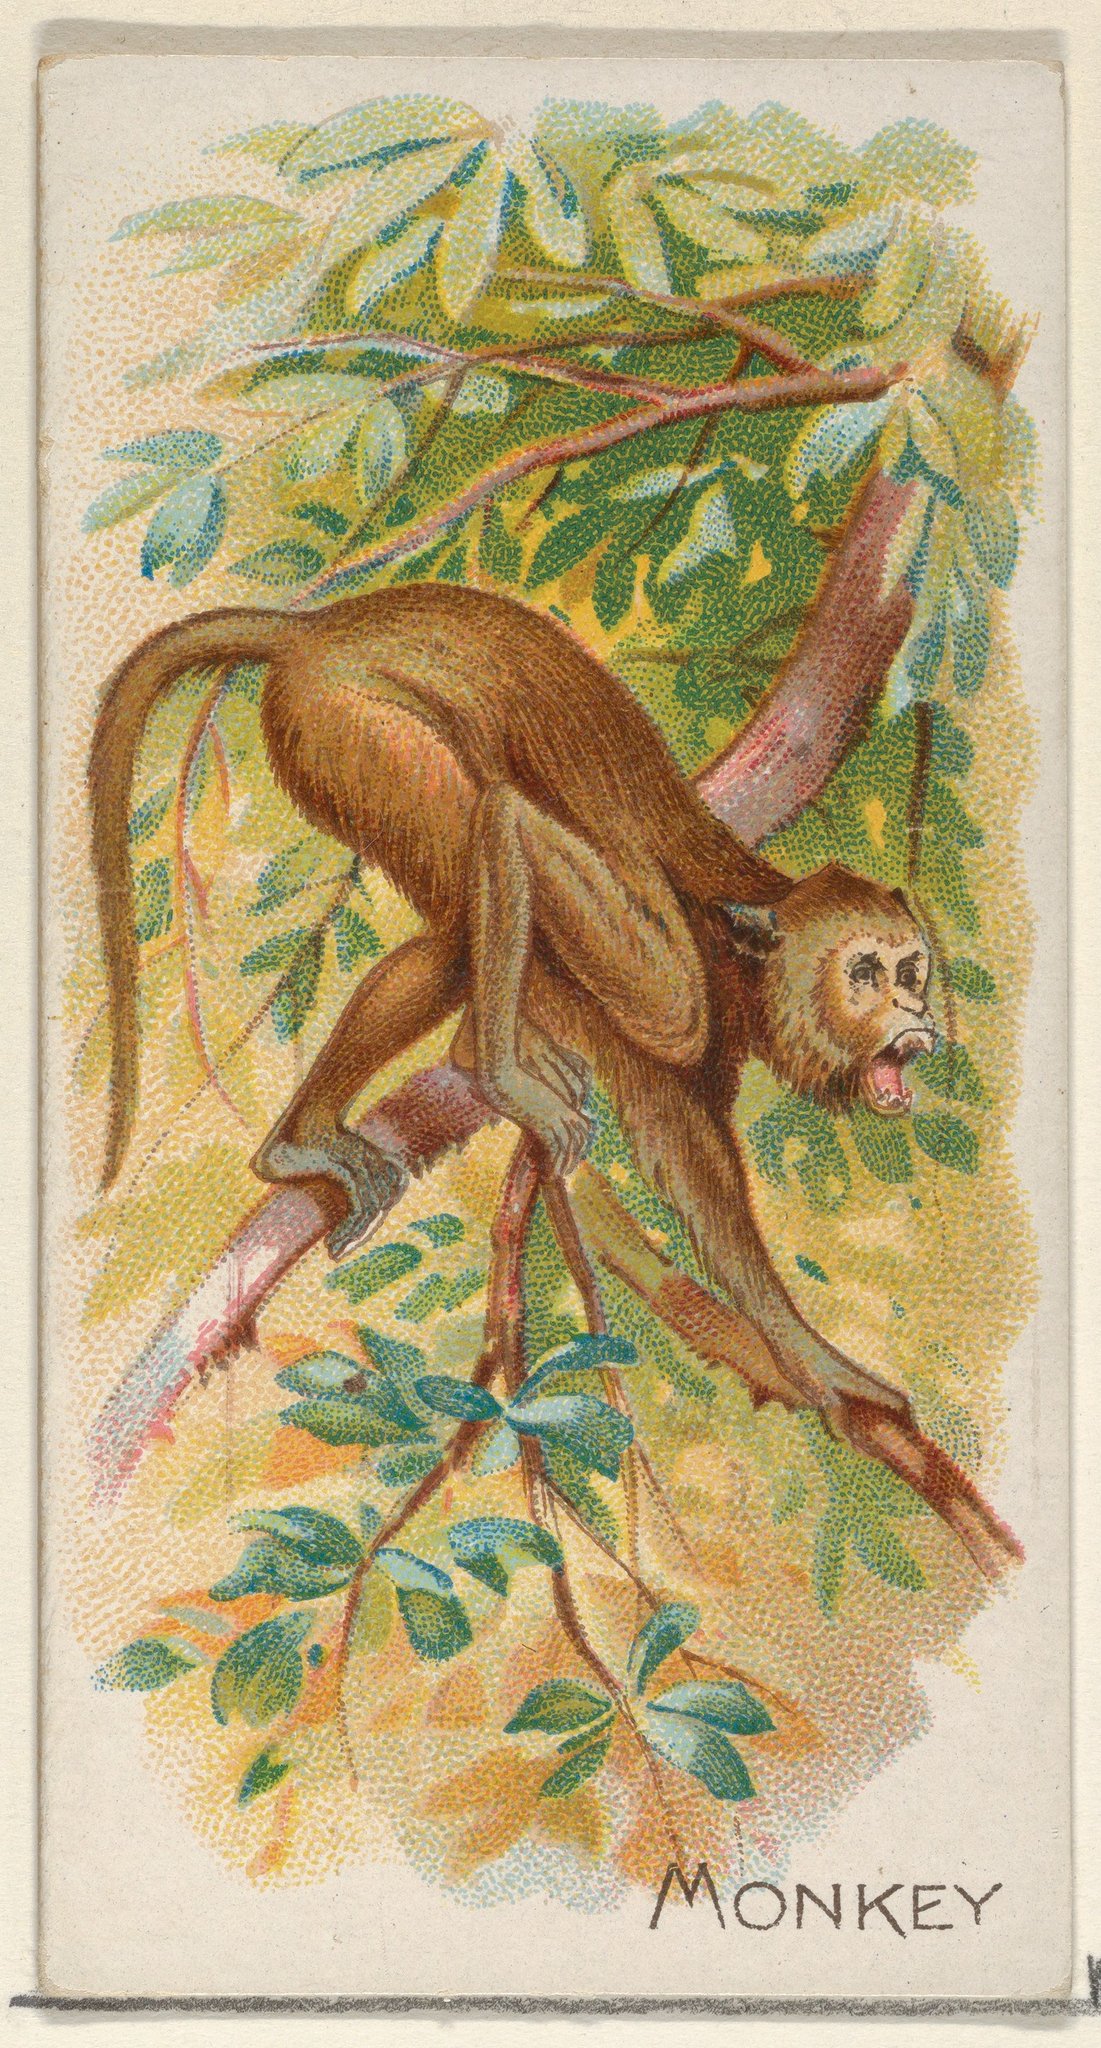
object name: print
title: Monkey, from the Quadrupeds series (N21) for Allen & Ginter Cigarettes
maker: allen & ginter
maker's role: publisher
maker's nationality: american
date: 1890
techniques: color lithograph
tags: monkeys